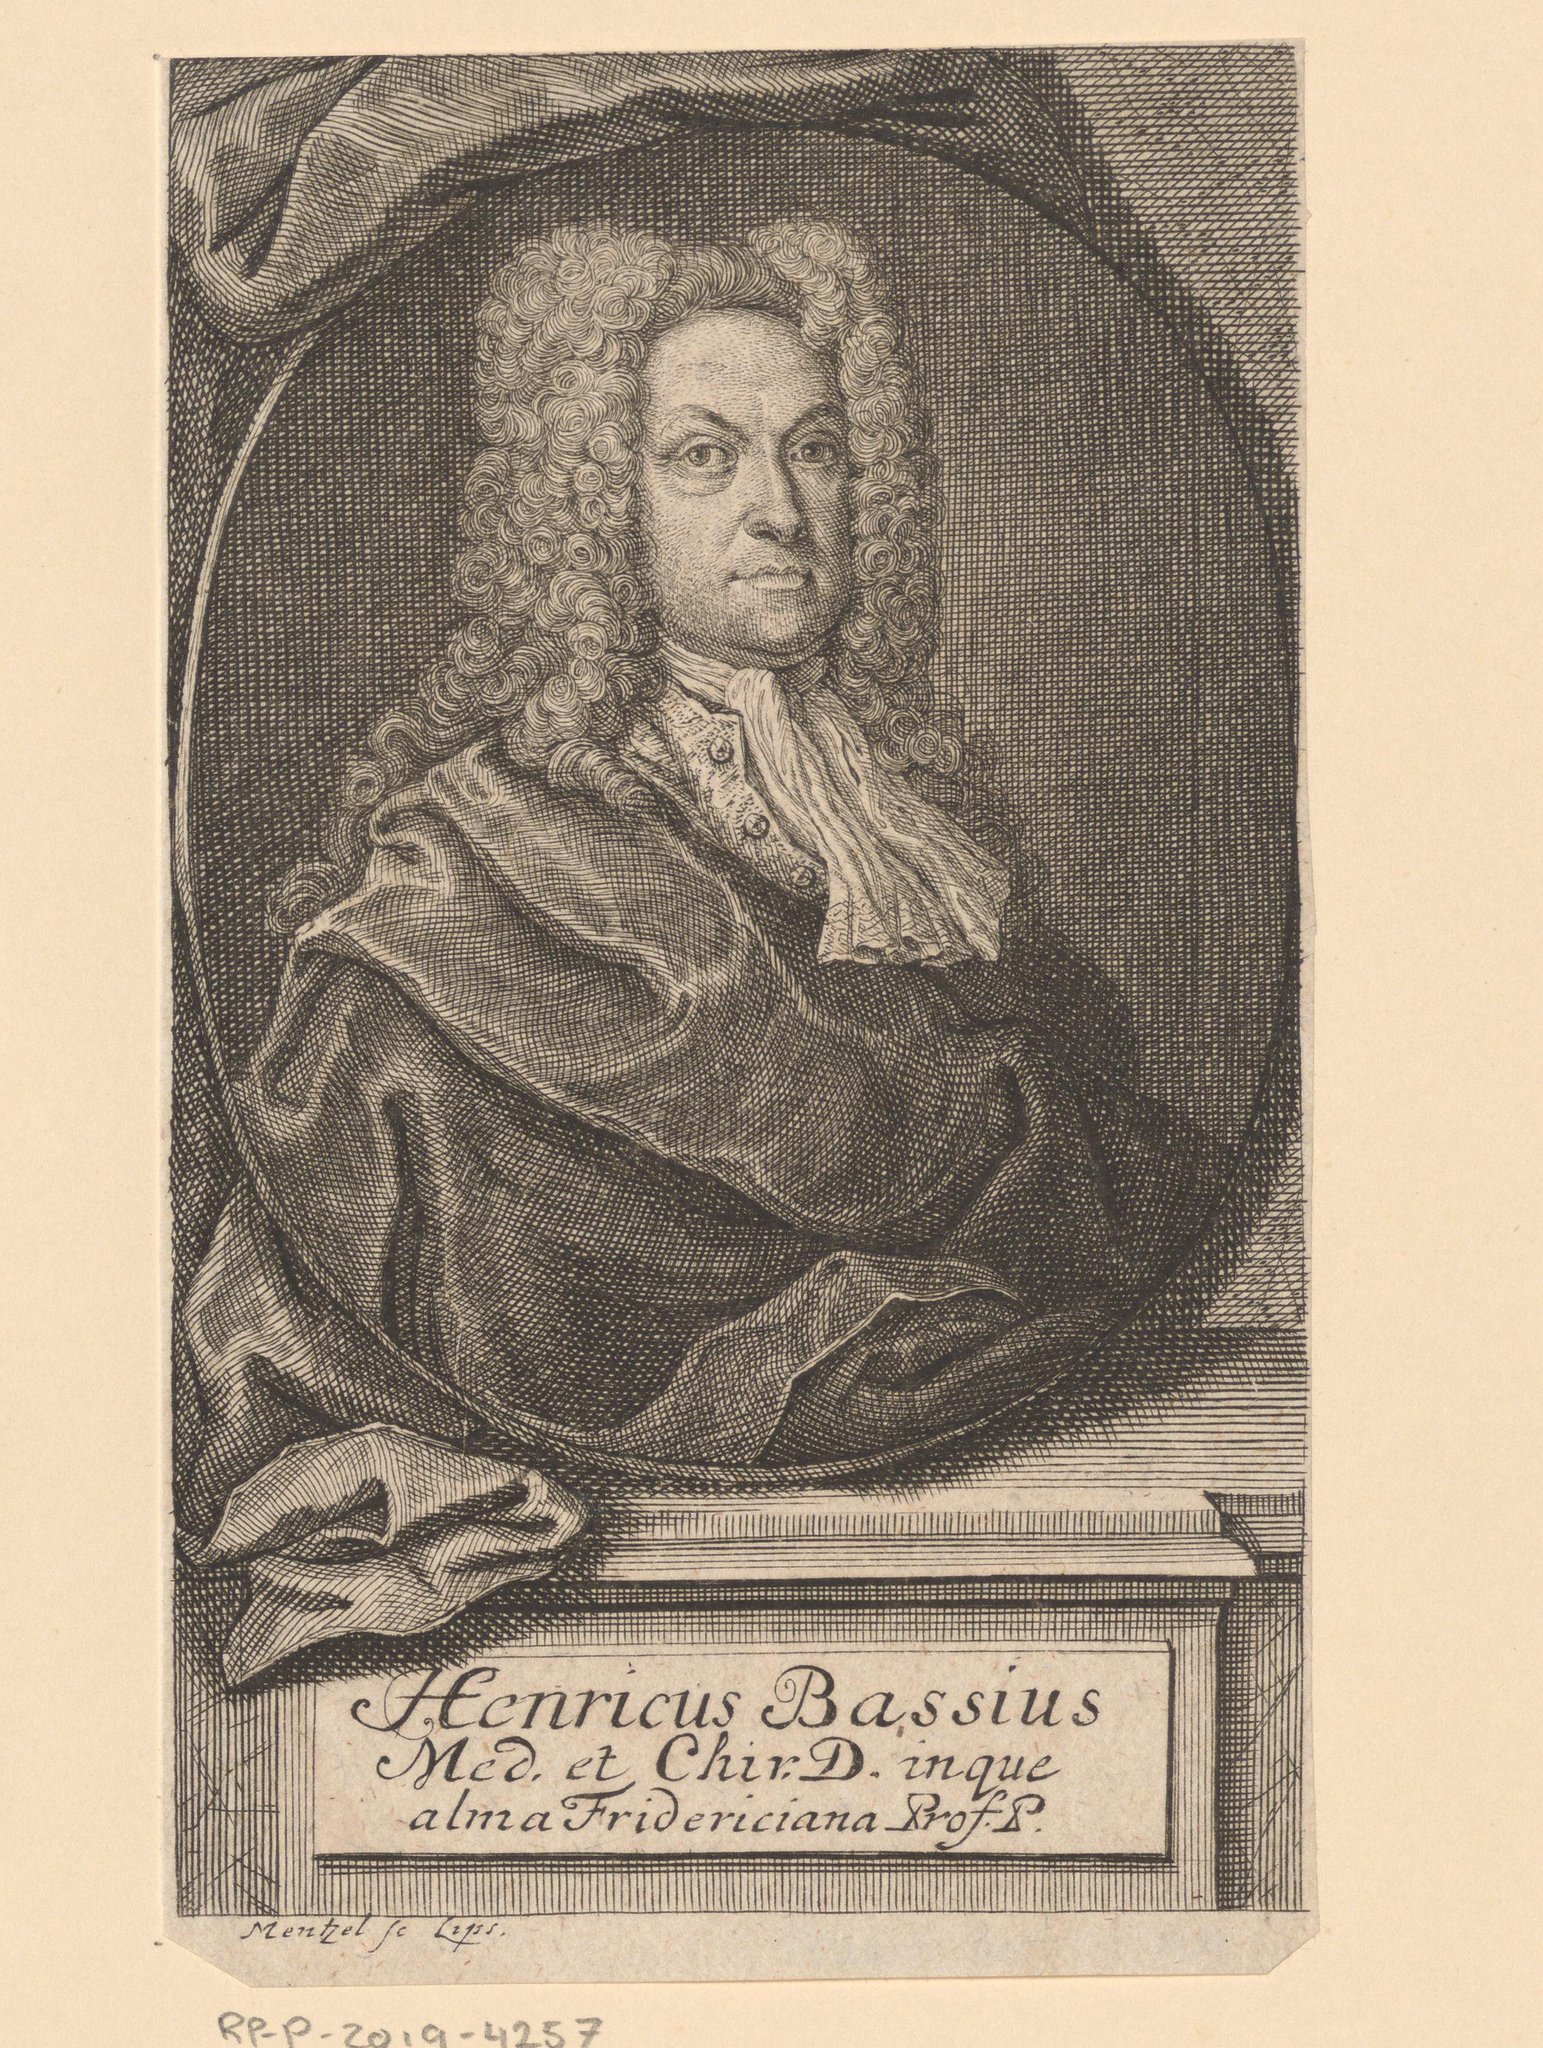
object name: print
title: Portret van Heinrich Bass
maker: johann georg mentzel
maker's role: print maker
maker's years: 1677-1743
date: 1731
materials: paper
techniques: engraving, etching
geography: leipzig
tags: historical persons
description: Prent uit: Bass, Heinrich. Observationes anatomico-chirurgico-medicae (...). Halle an der Saale: erven Johann Gottfried Renger, 1731.